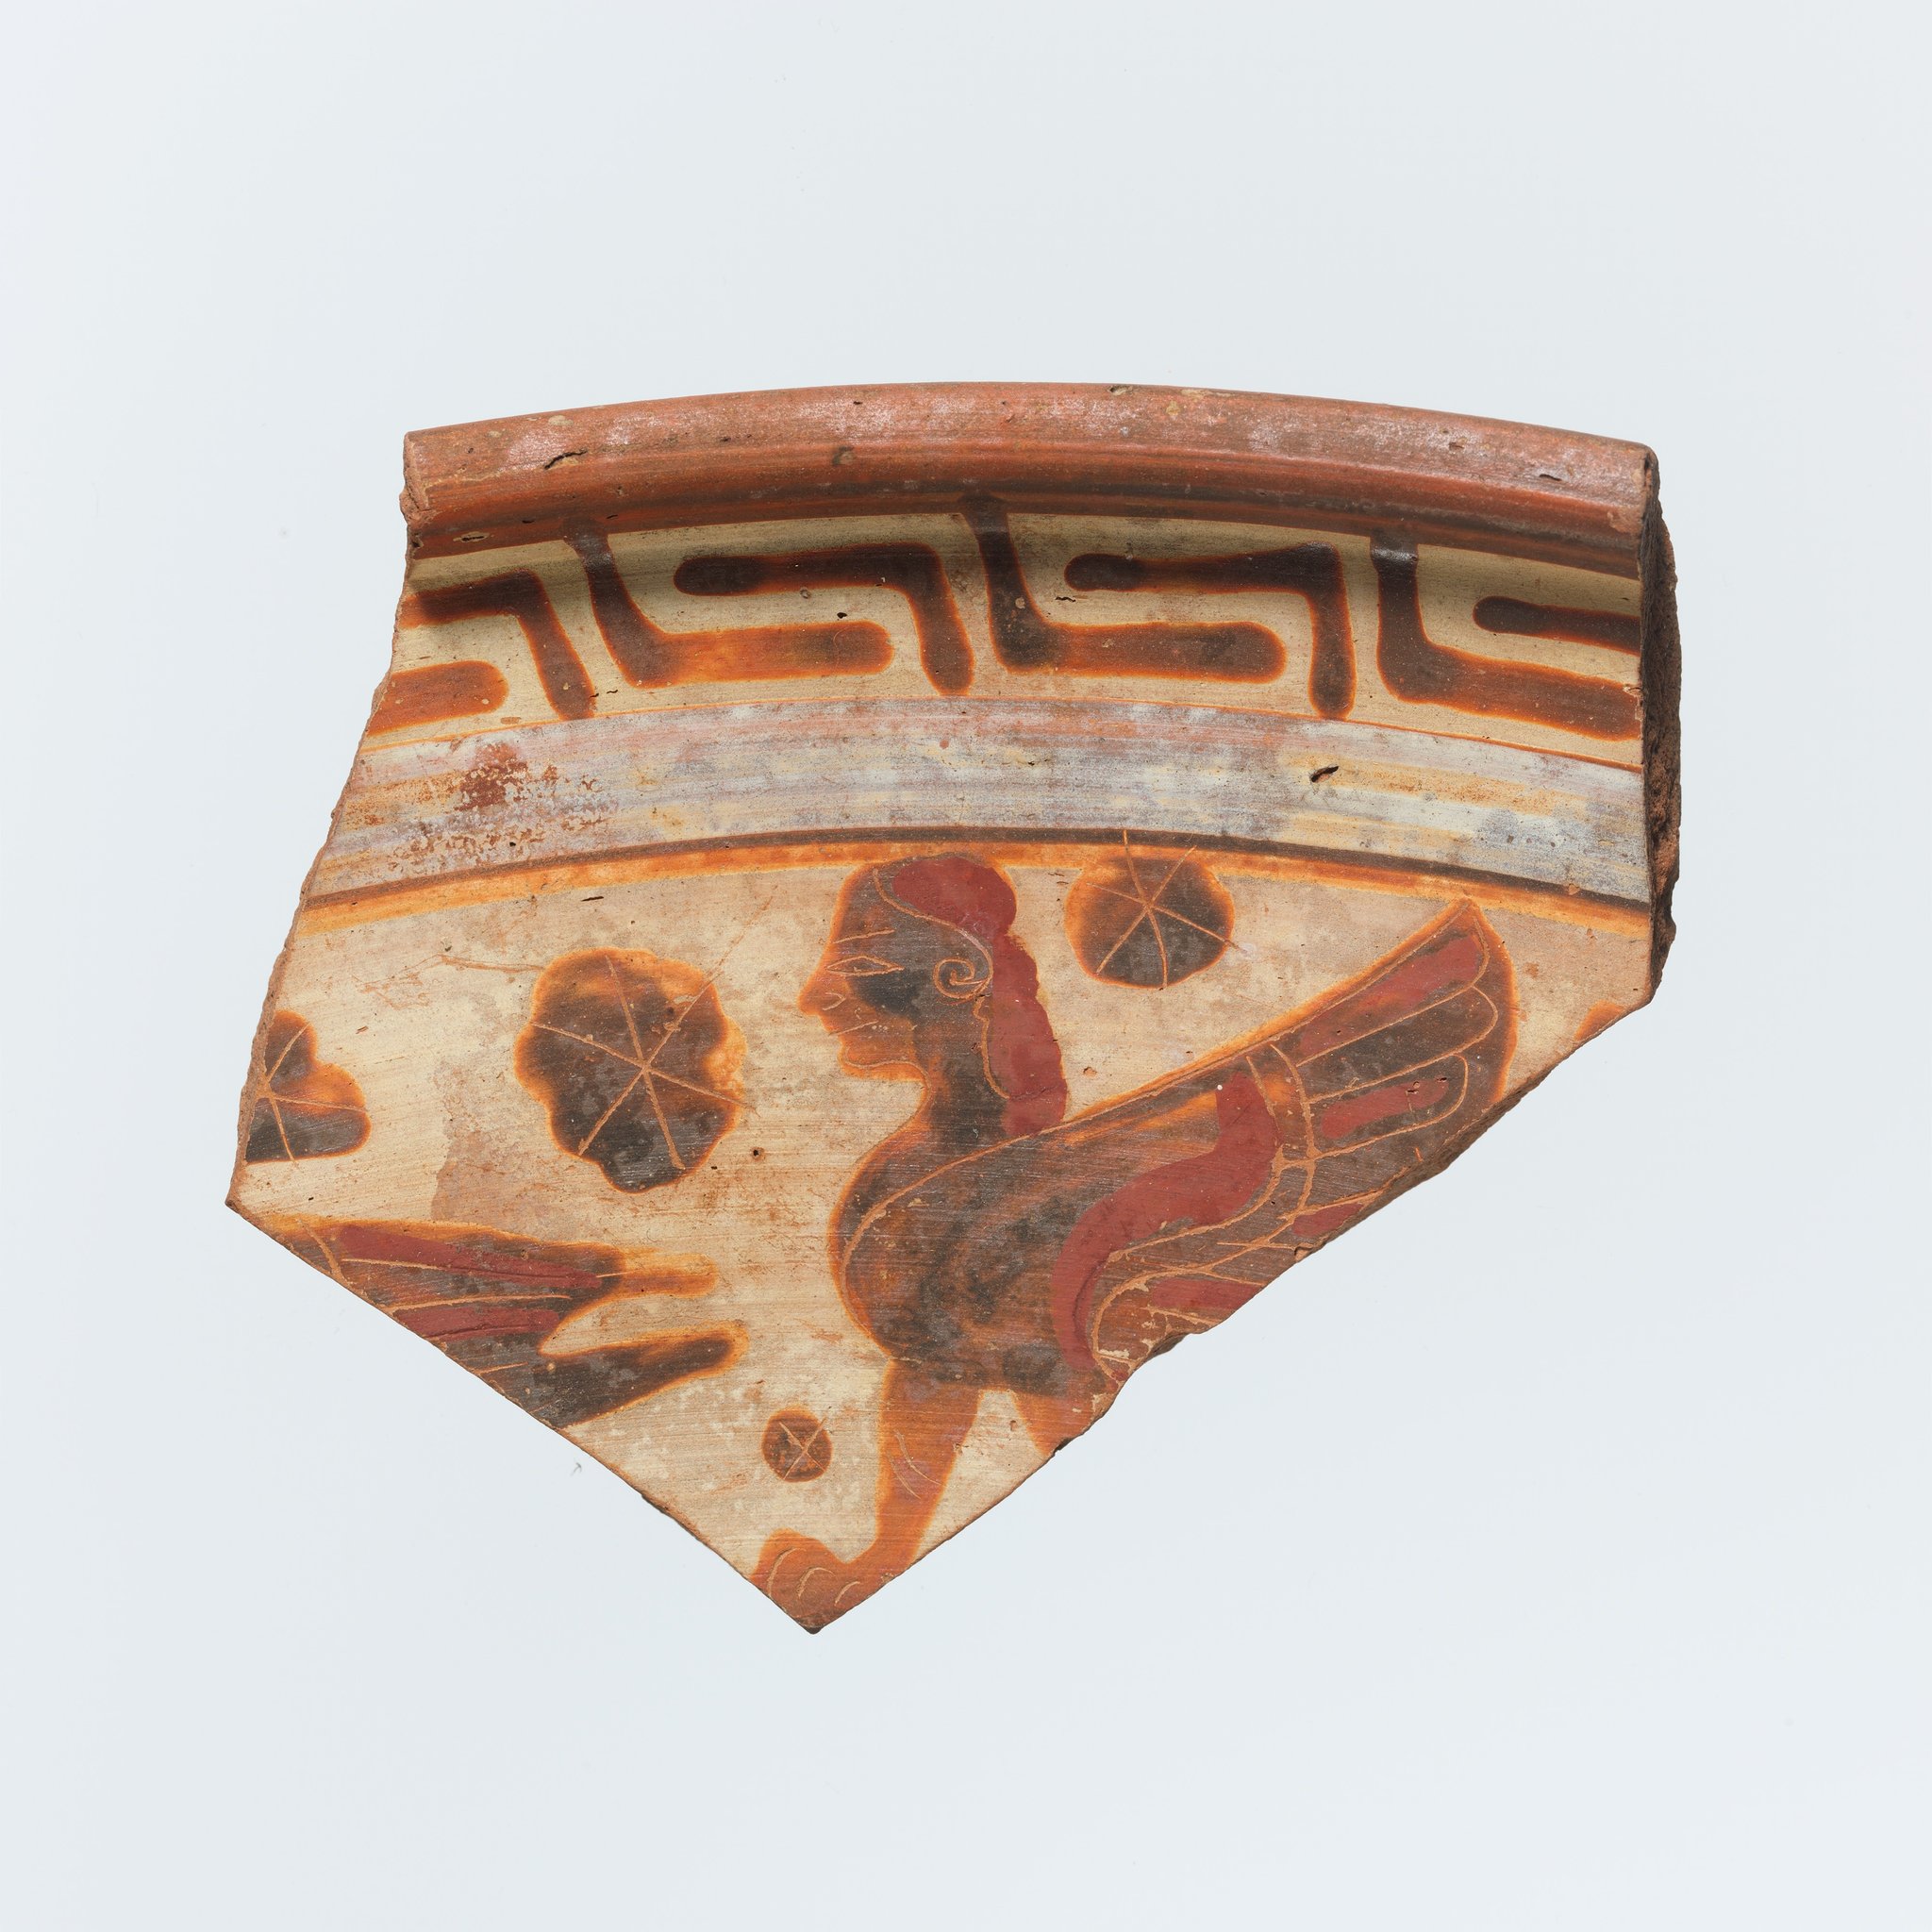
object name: plate fragment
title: Fragment of a terracotta plate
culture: greek, east, clazomenian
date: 600-501 BCE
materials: terracotta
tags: sphinx